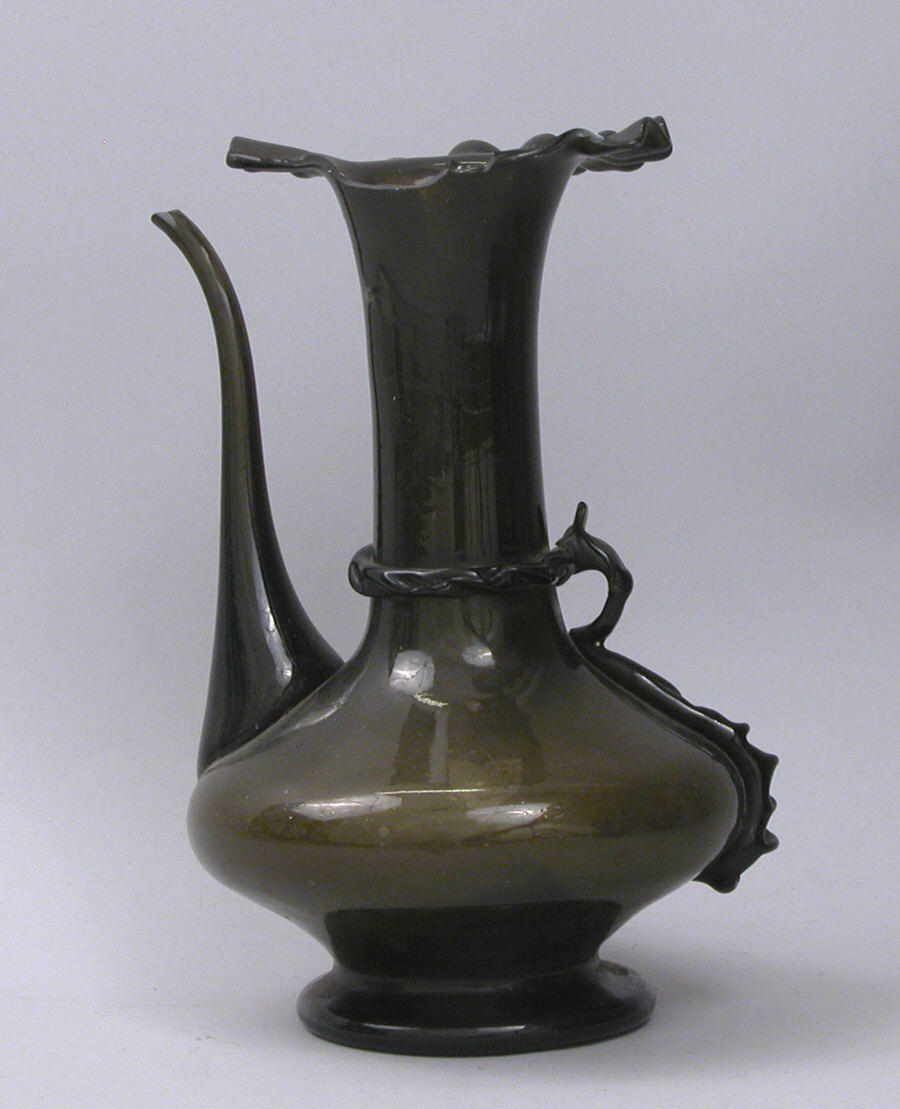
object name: ewer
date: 1701-1900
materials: glass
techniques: glassblowing, tooling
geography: iran